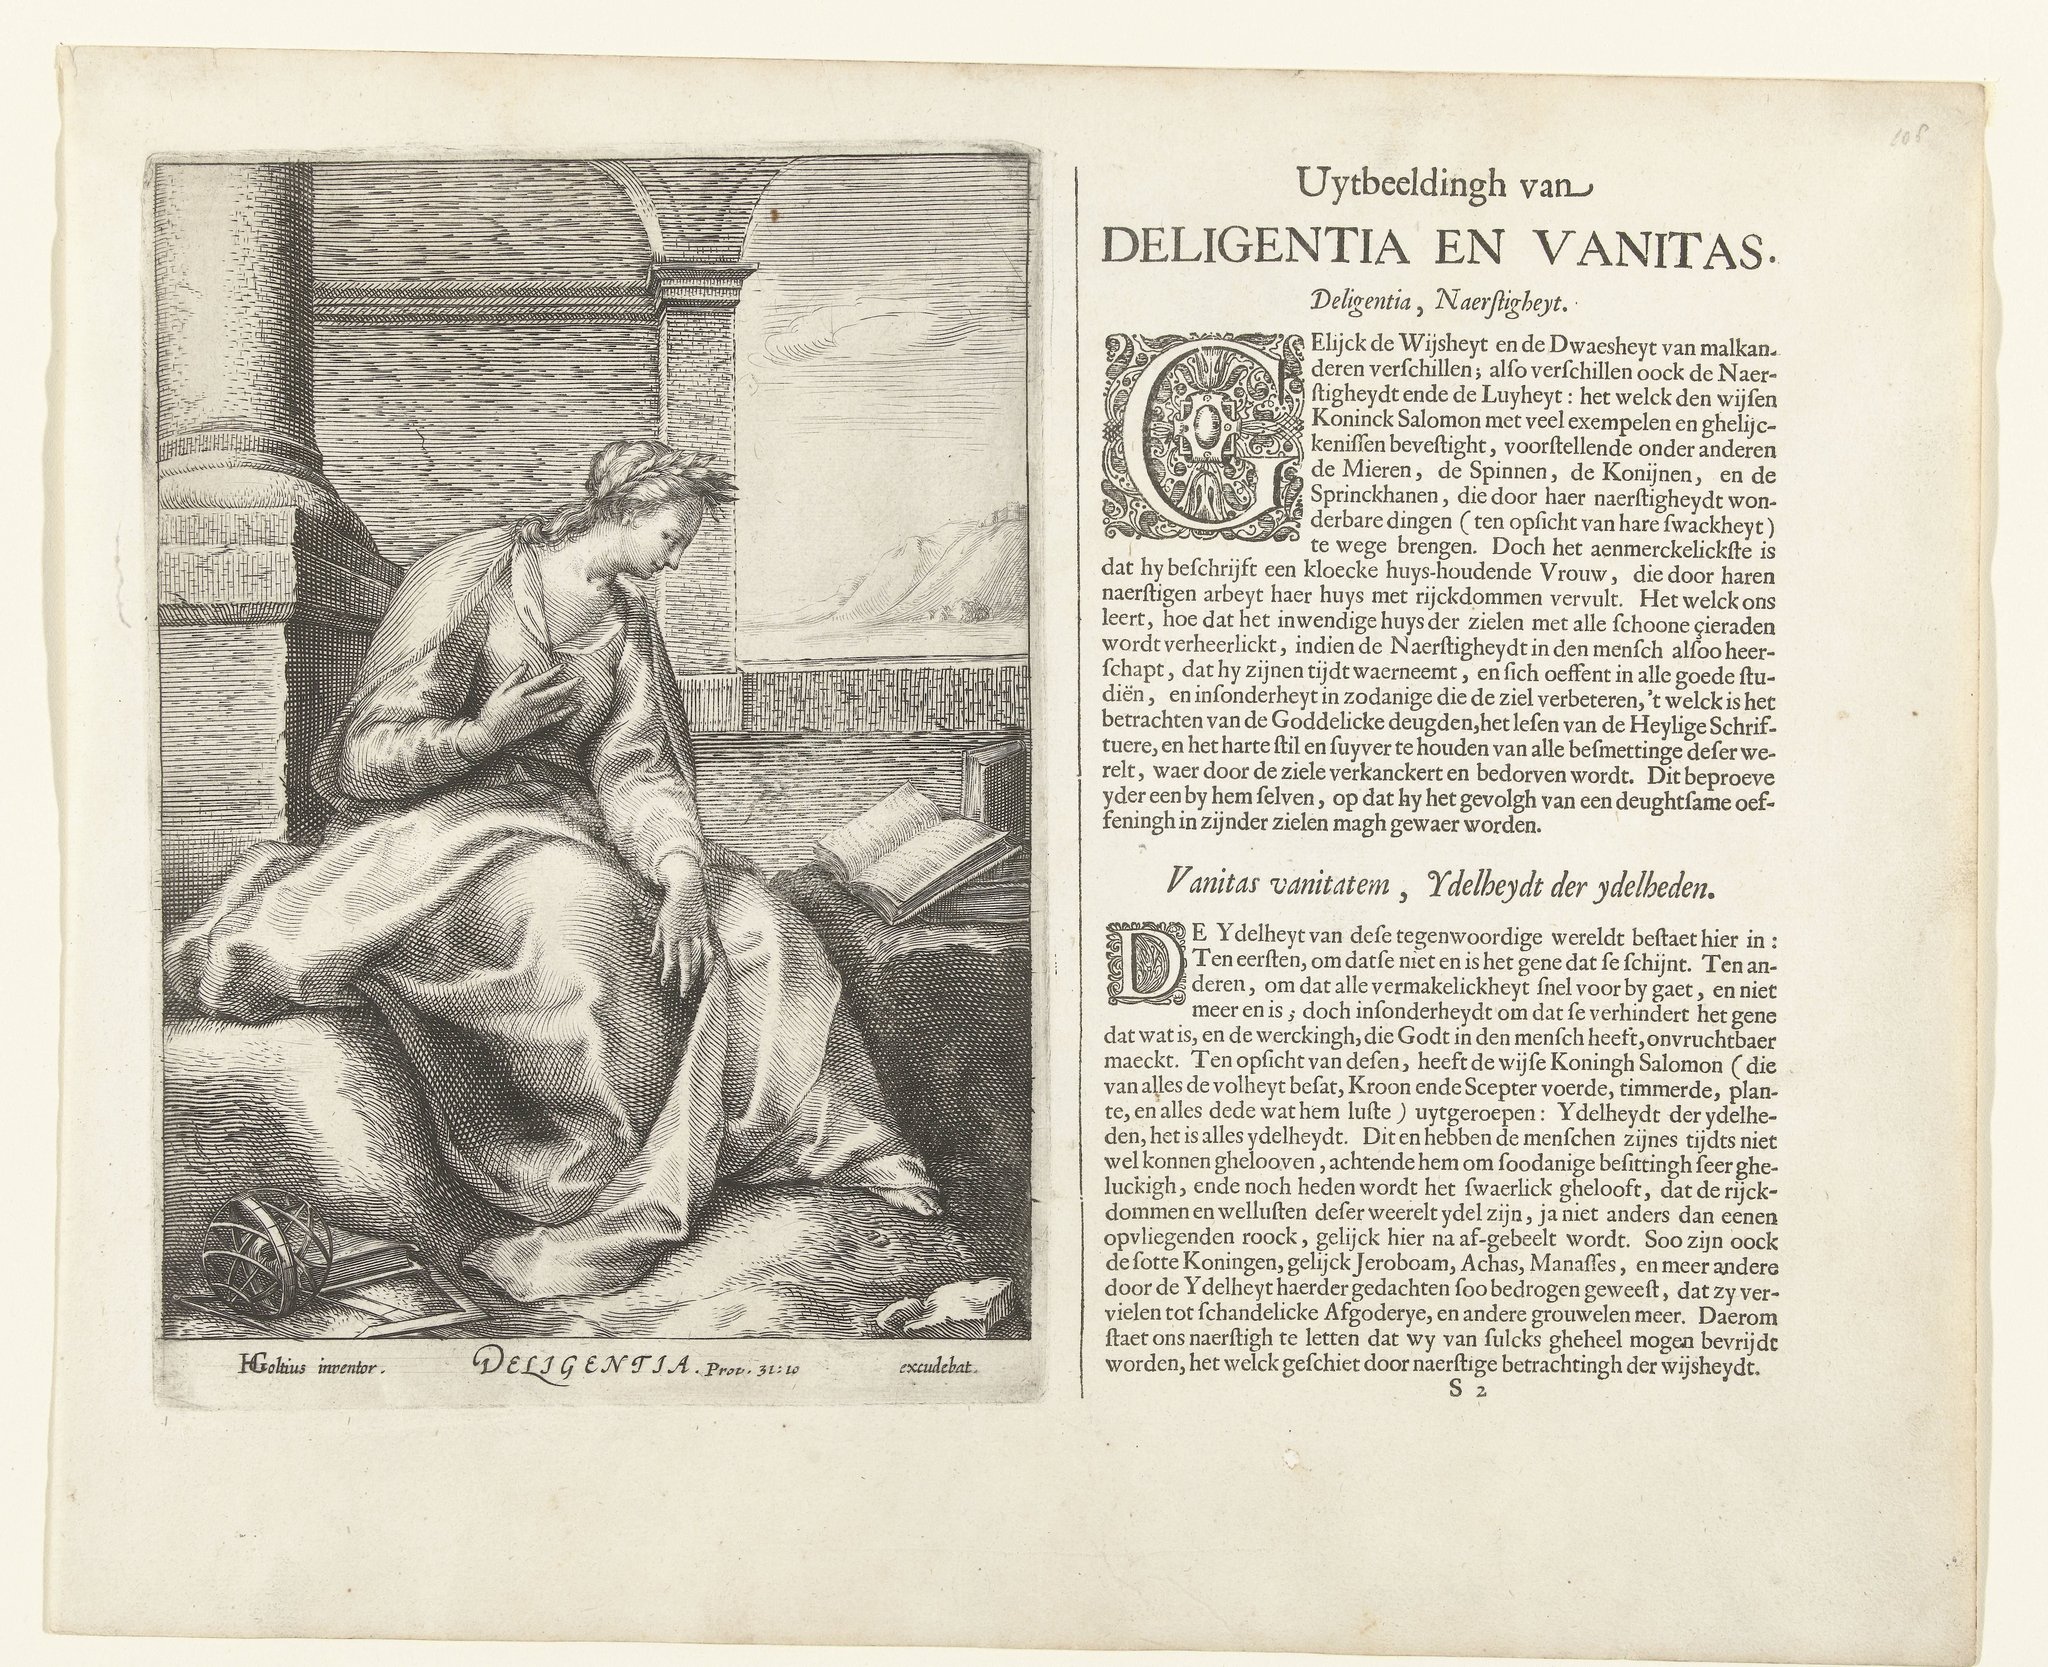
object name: print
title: Naarstigheid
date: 1654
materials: paper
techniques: engraving, letterpress printing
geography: low countries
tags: carefulness, diligence; 'diligenza' (ripa)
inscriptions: collector's mark: Lugt 2228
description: Verbeelding van de naarstigheid, in de gedaante van een vrouw die met de hand op de borst leest in een boek. Onder de voorstelling een regel Latijnse tekst. Deze prent is gedrukt op een blad, waarop ook tekst in boekdruk (rechts naast de afbeelding): 'Uytbeeldingh van deligentia en vanitas. Deligentia, Naerstigheyt. Gelijck de Wijsheyt en de Dwaesheyt ...betrachting der wijsheydt.'